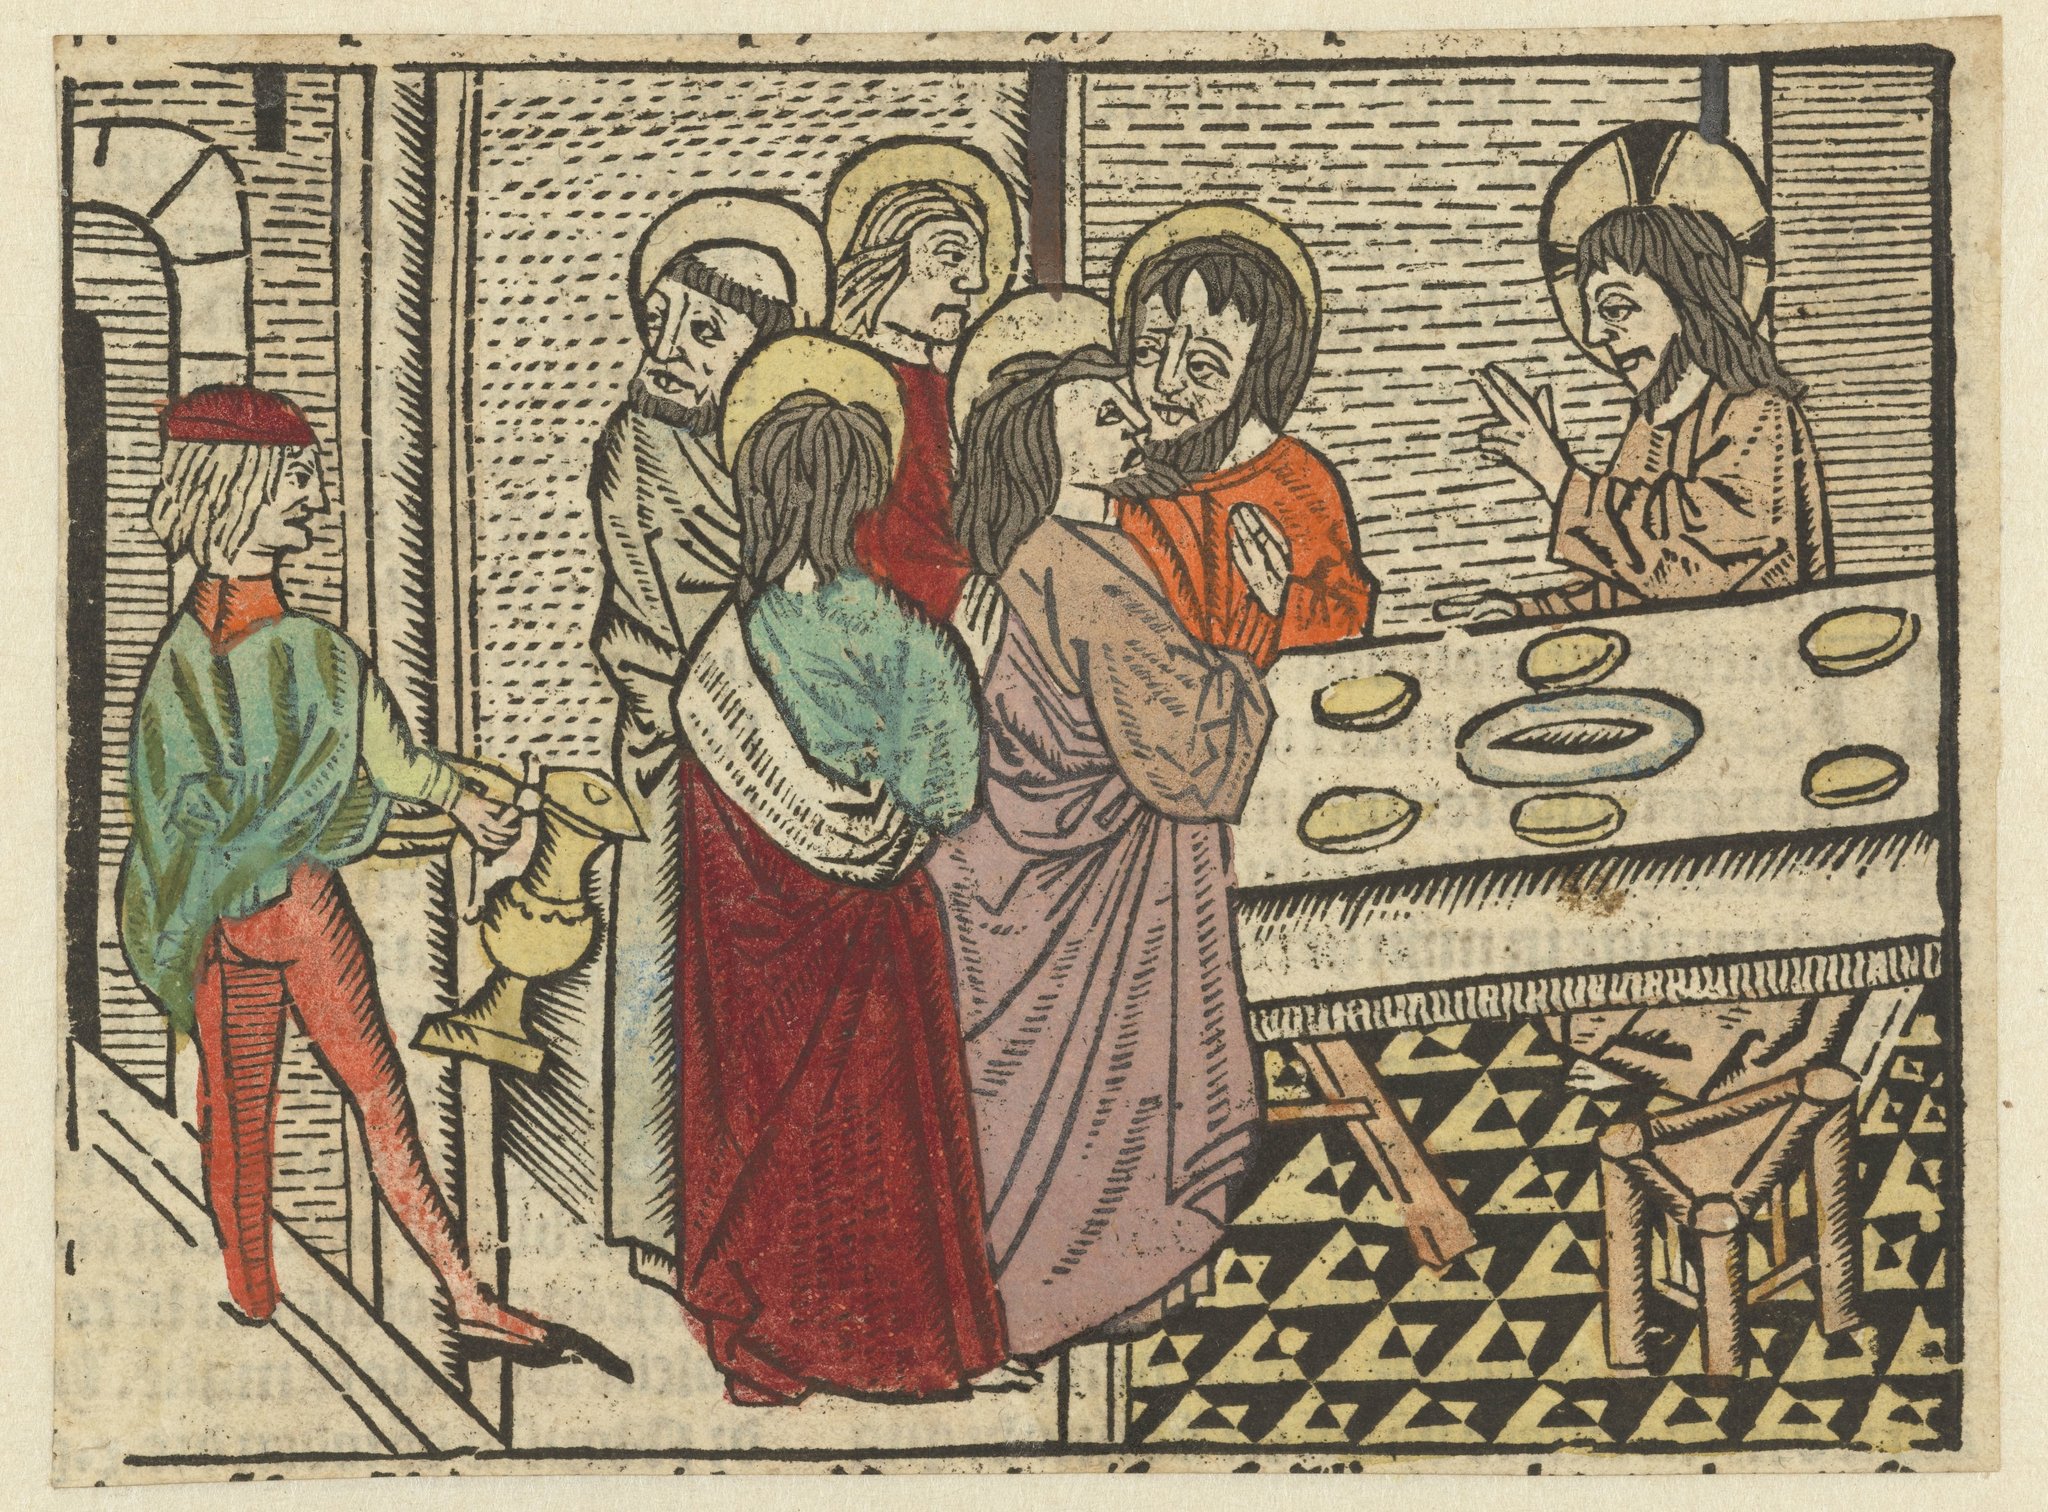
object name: print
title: Christus en zijn discipelen in het huis van de Farizeeër weigeren de rituele handwassing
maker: meester van gouda (ii)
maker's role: print maker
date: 1482-1484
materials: paper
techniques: hand coloring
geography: low countries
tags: meal at the house of a pharisee; christ and his disciples do not submit to the ritual washing (luke 11:37-41)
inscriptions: collector's mark: Lugt 2228a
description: Eén van 46 houtsnedes uit Ludolphus de Saxonia "Tboeck vandan leven ons heeren Jesu Christi", een anonieme Nederlandse vertaling. Deze versie van het werk van Ludolphus bevat houtsneden van de Meester van Gouda (II), de Meester van Antwerpen (I) en de Meester van Haarlem. Botke, K. Boek van Ludolphus is voor het eerst uitgegeven in 1487 door Geeraert Leeu te Antwerpen. In 1488 uitgegeven door Claes Leeu te Antwerpen, in 1495 en 1499 en 1519 door Peter van Os te Zwolle en in 1510 door A. van Berghen te Antwerpen. Deze 46 houtsneden komen waarschijnlijk uit een uitgave van Peter van Os. Botke, K.